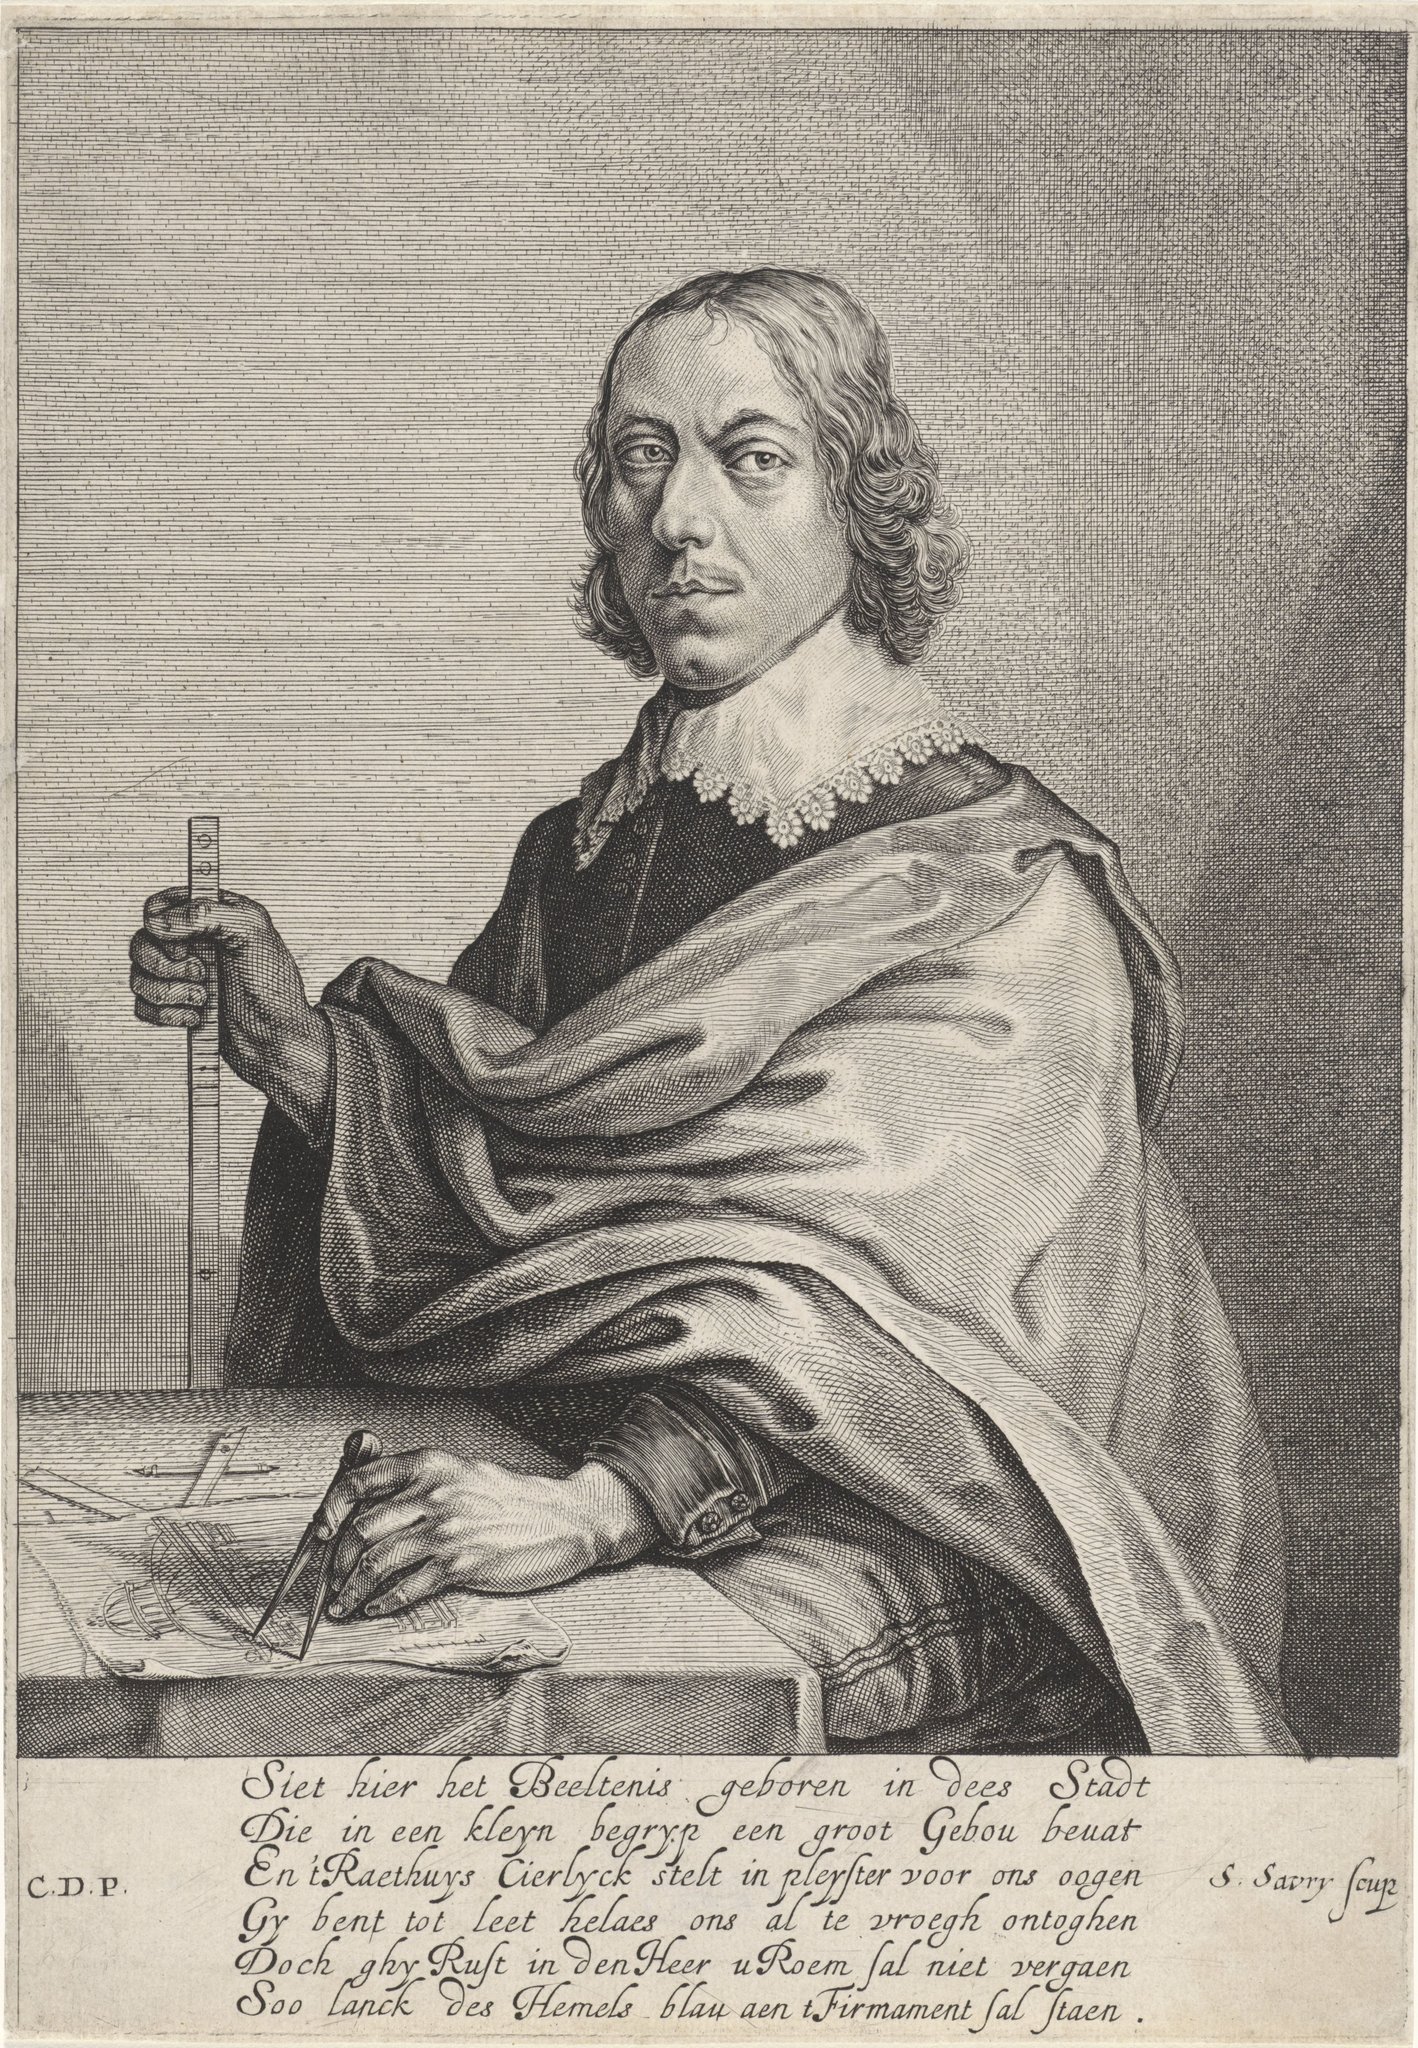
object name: print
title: Portret van de architect Jacob Vennekool met een ontwerp voor het stadhuis op de Dam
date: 1648-1665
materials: paper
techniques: engraving, etching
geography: amsterdam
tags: sculptor, jacob vennekool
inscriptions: collector's mark: Lugt 2228